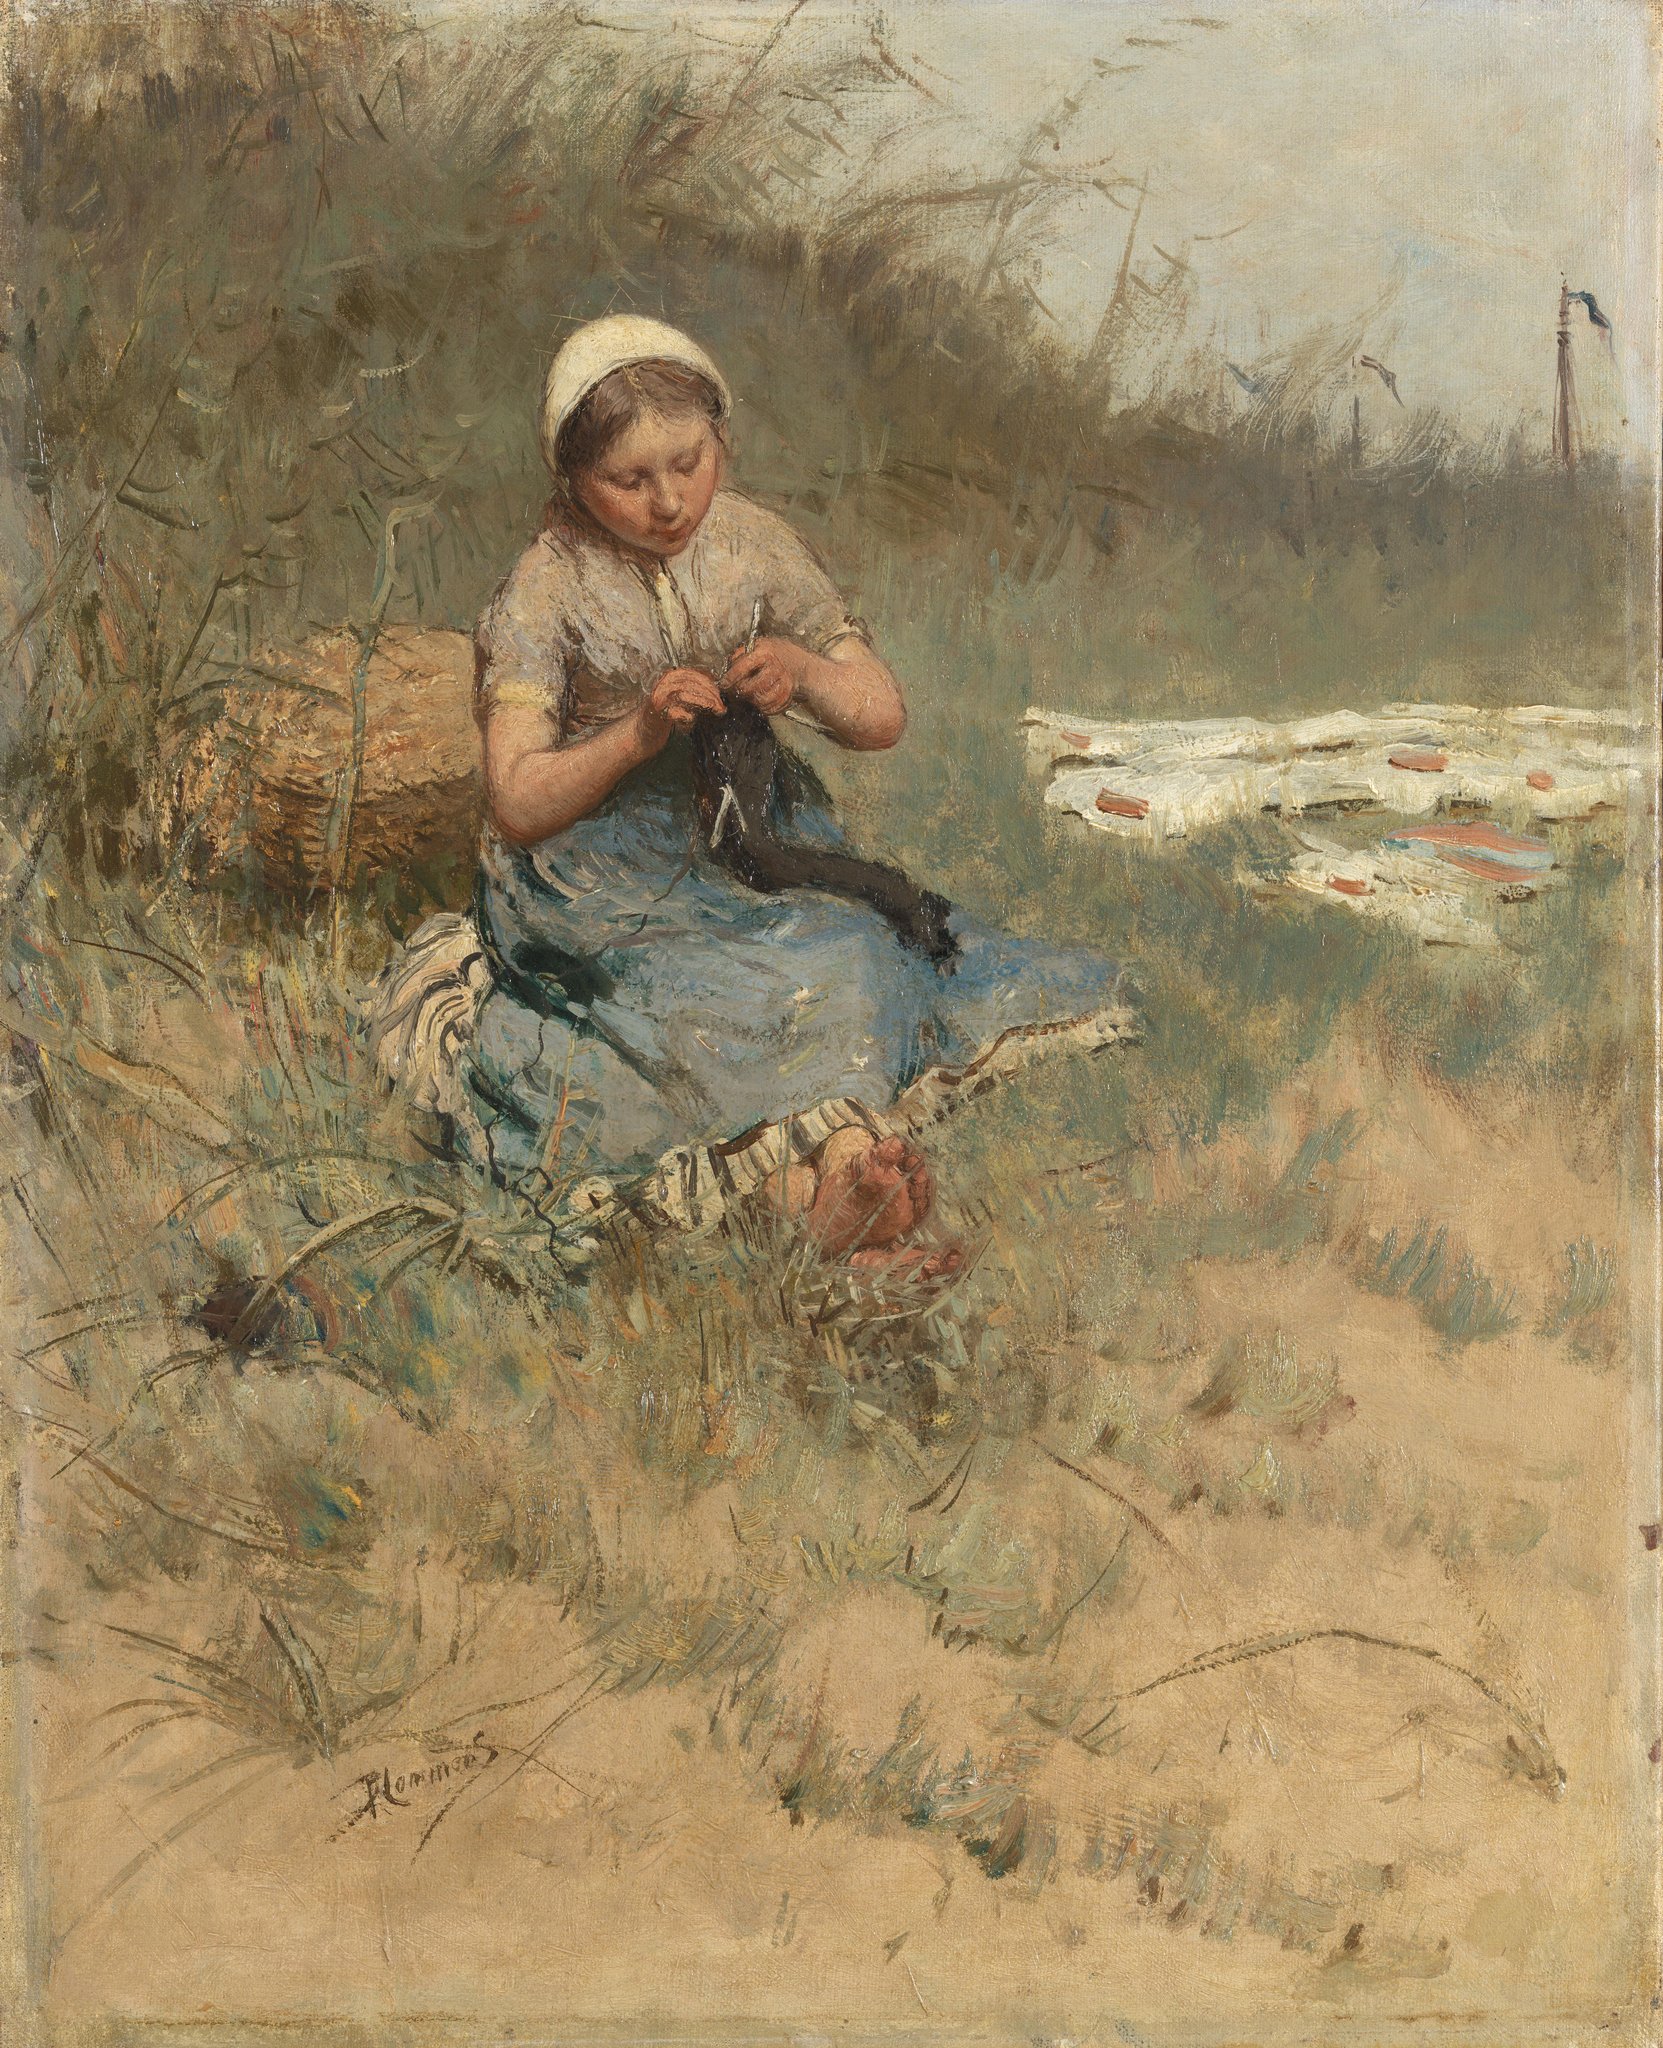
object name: painting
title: Girl Knitting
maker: bernardus johannes blommers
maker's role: draughtsman, print maker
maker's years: 1845-1914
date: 1885-1886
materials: canvas, oil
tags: adolescent, young woman, maiden, dunes (sea not visible); in the dunes, knitting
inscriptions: signature: ‘Blommers’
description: Het breistertje. Duinlandschap waarin een meisje zit te breien.